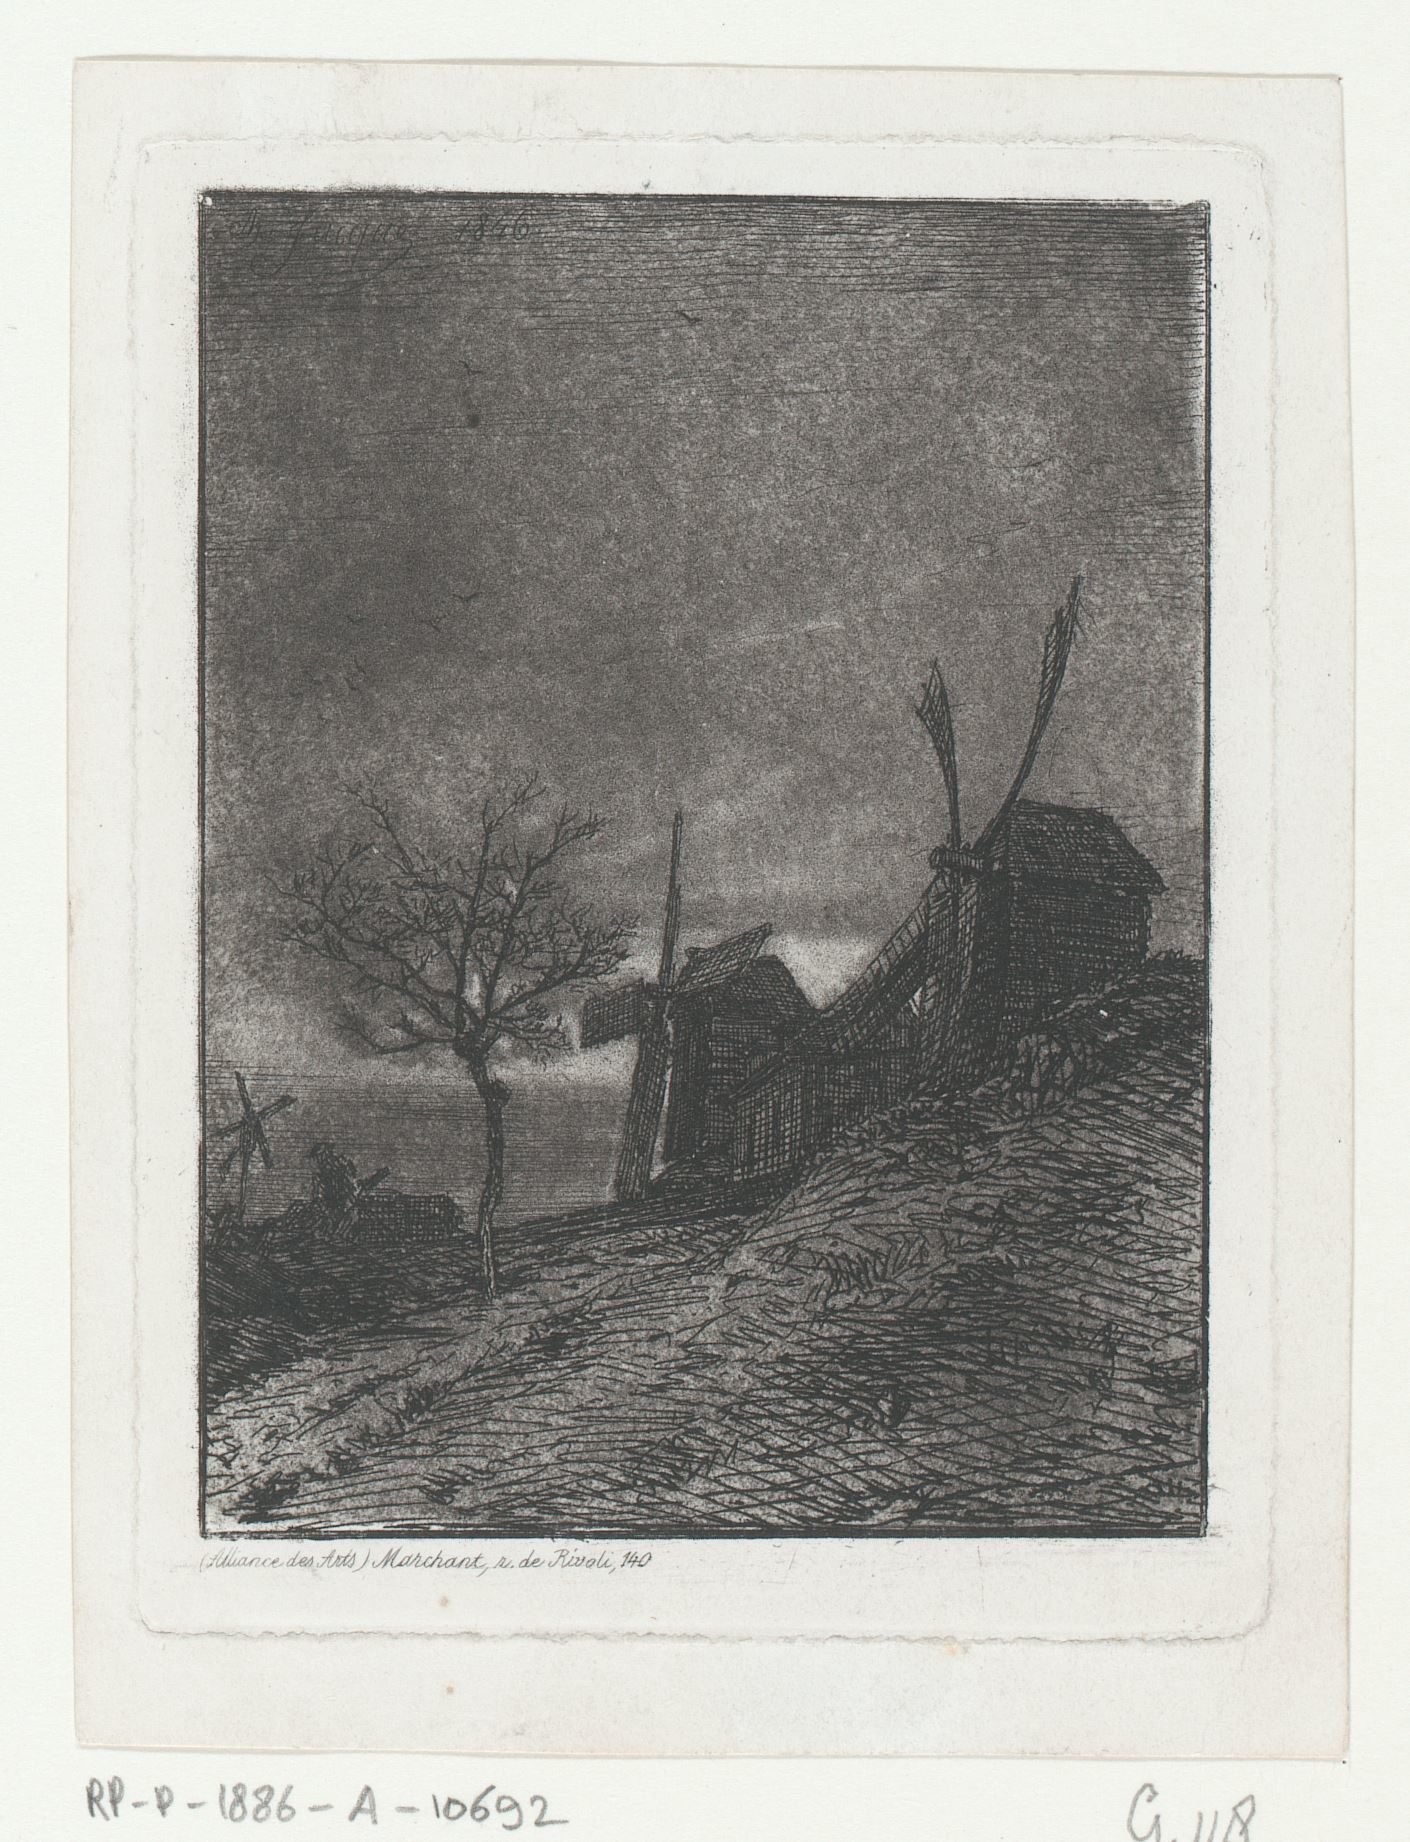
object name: print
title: Molens op een helling, mogelijk te Montmartre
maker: charles emile jacque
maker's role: draughtsman, painter, print maker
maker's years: 1813-1894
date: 1846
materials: paper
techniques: etching, intaglio, roulette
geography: paris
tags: windmill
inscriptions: collector's mark: Lugt 2228